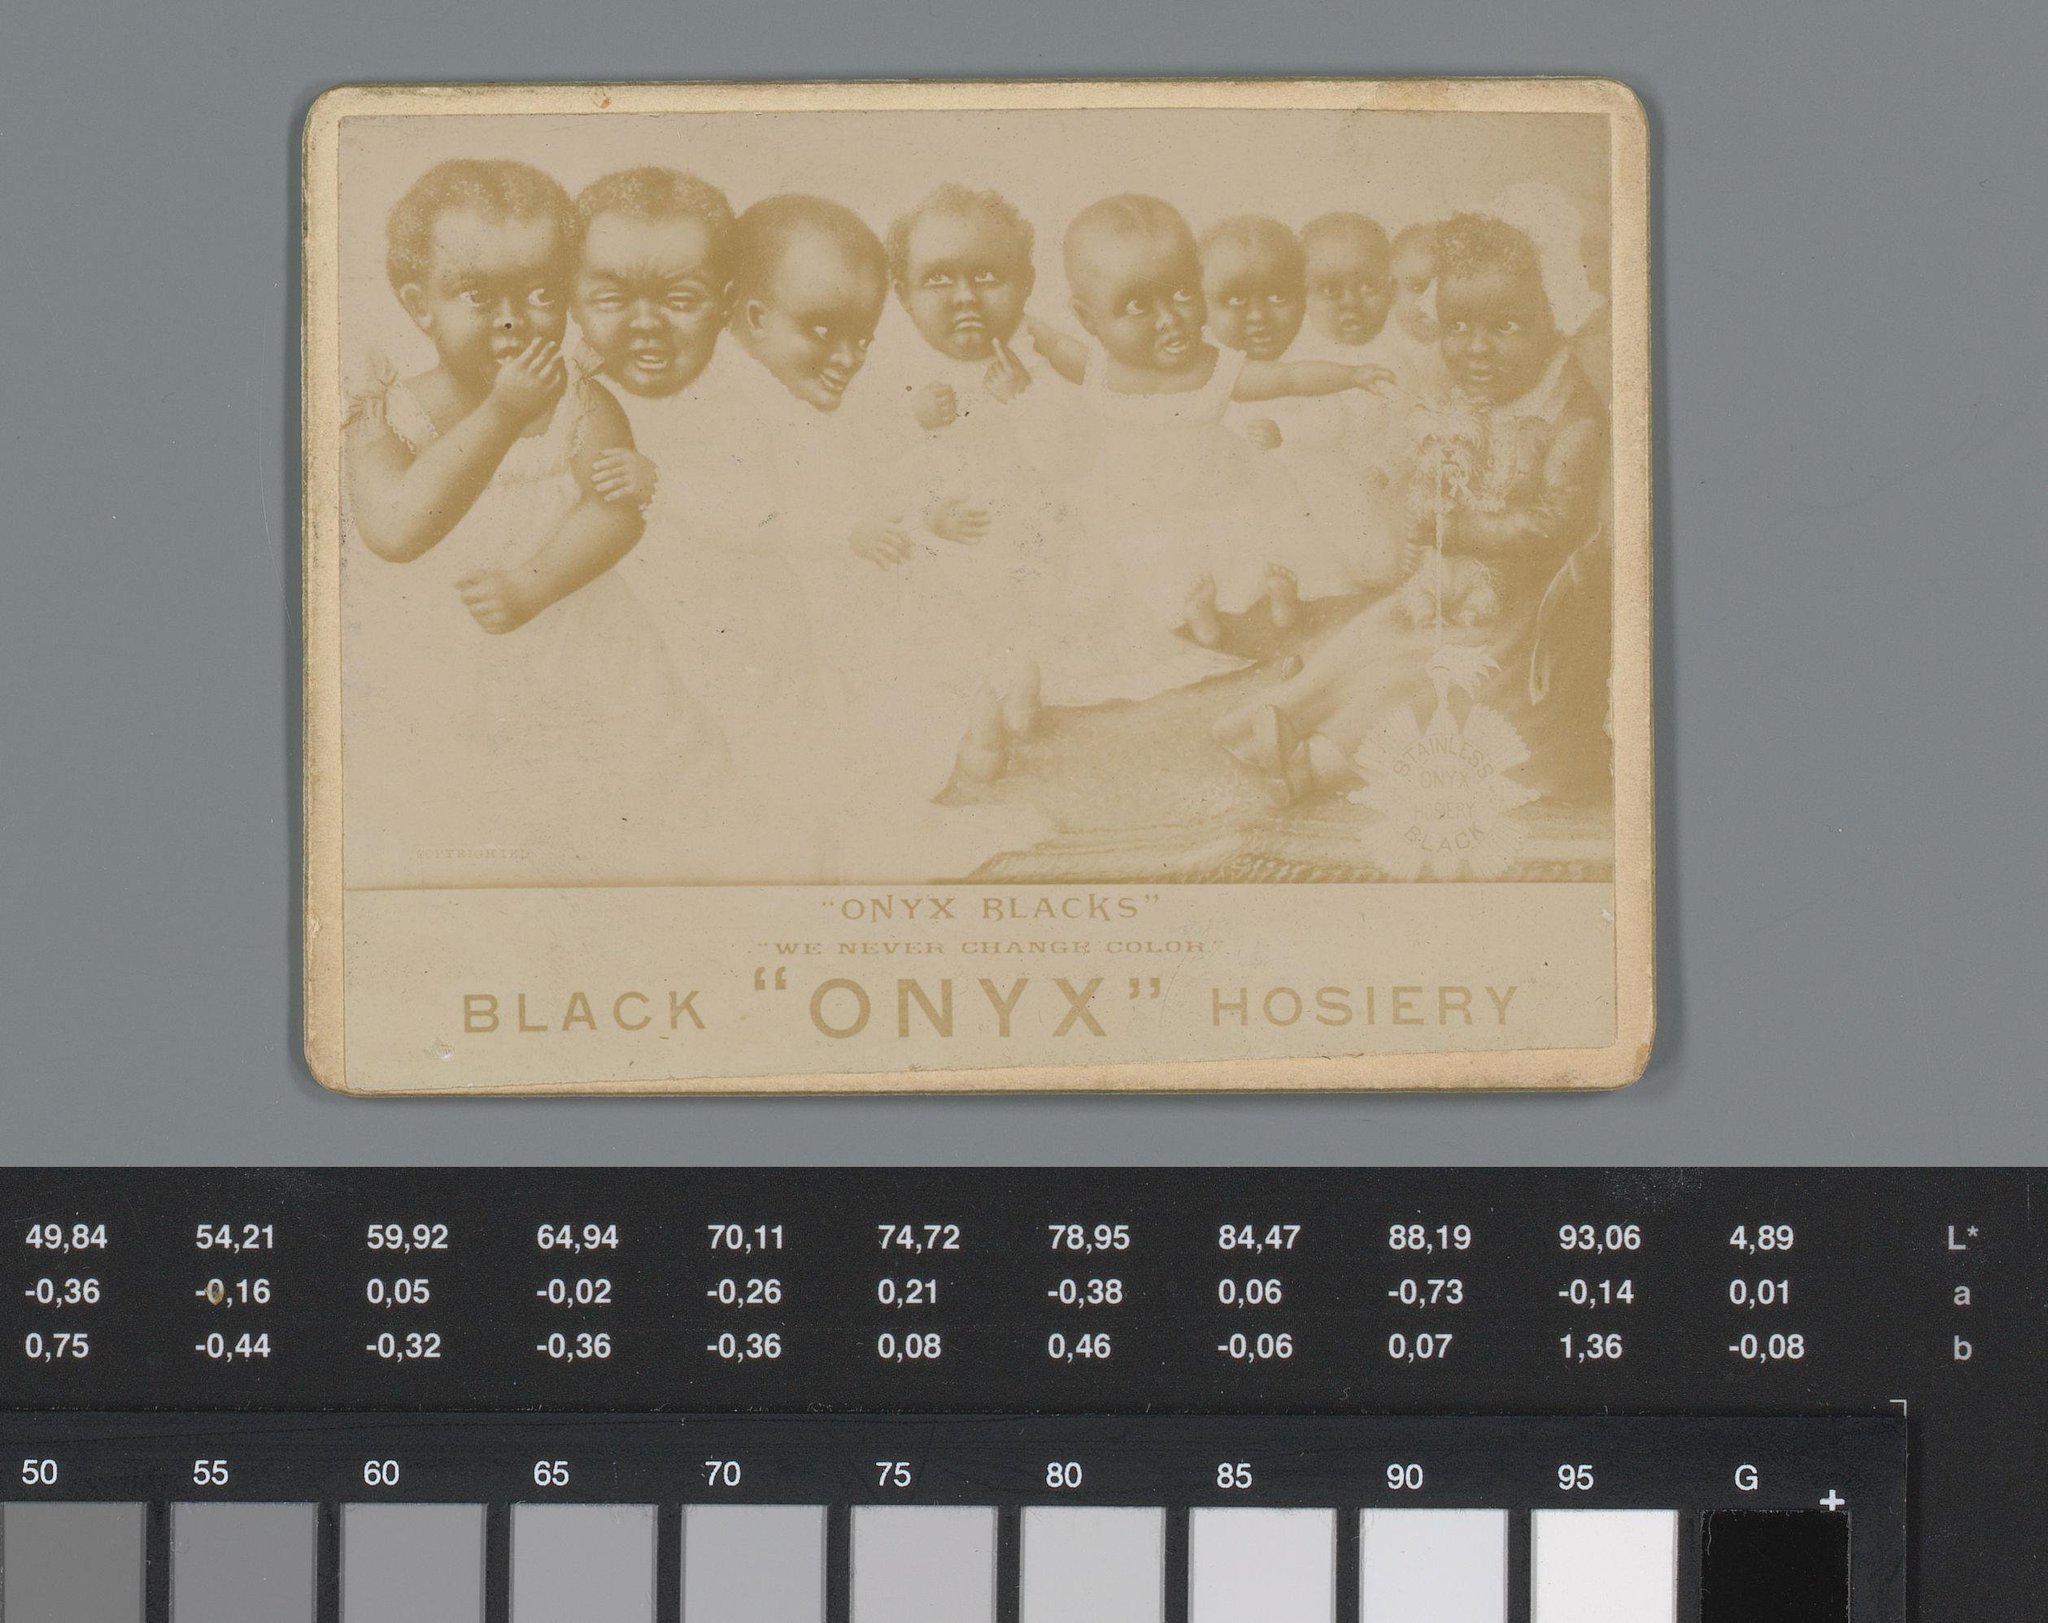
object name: photograph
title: Reclame voor zwarte kousen van Onyx met reproductie van een racistische prent van negen baby's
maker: Anonymous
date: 1850-1915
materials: cardboard, photographic support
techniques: albumen print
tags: advertising, african peoples, africans (+ caricatured), infant, baby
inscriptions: inscription: ‘"ONYX BLACKS" / "WE NEVER CHANGE COLOR" / BLACK "ONYX" HOSIERY’